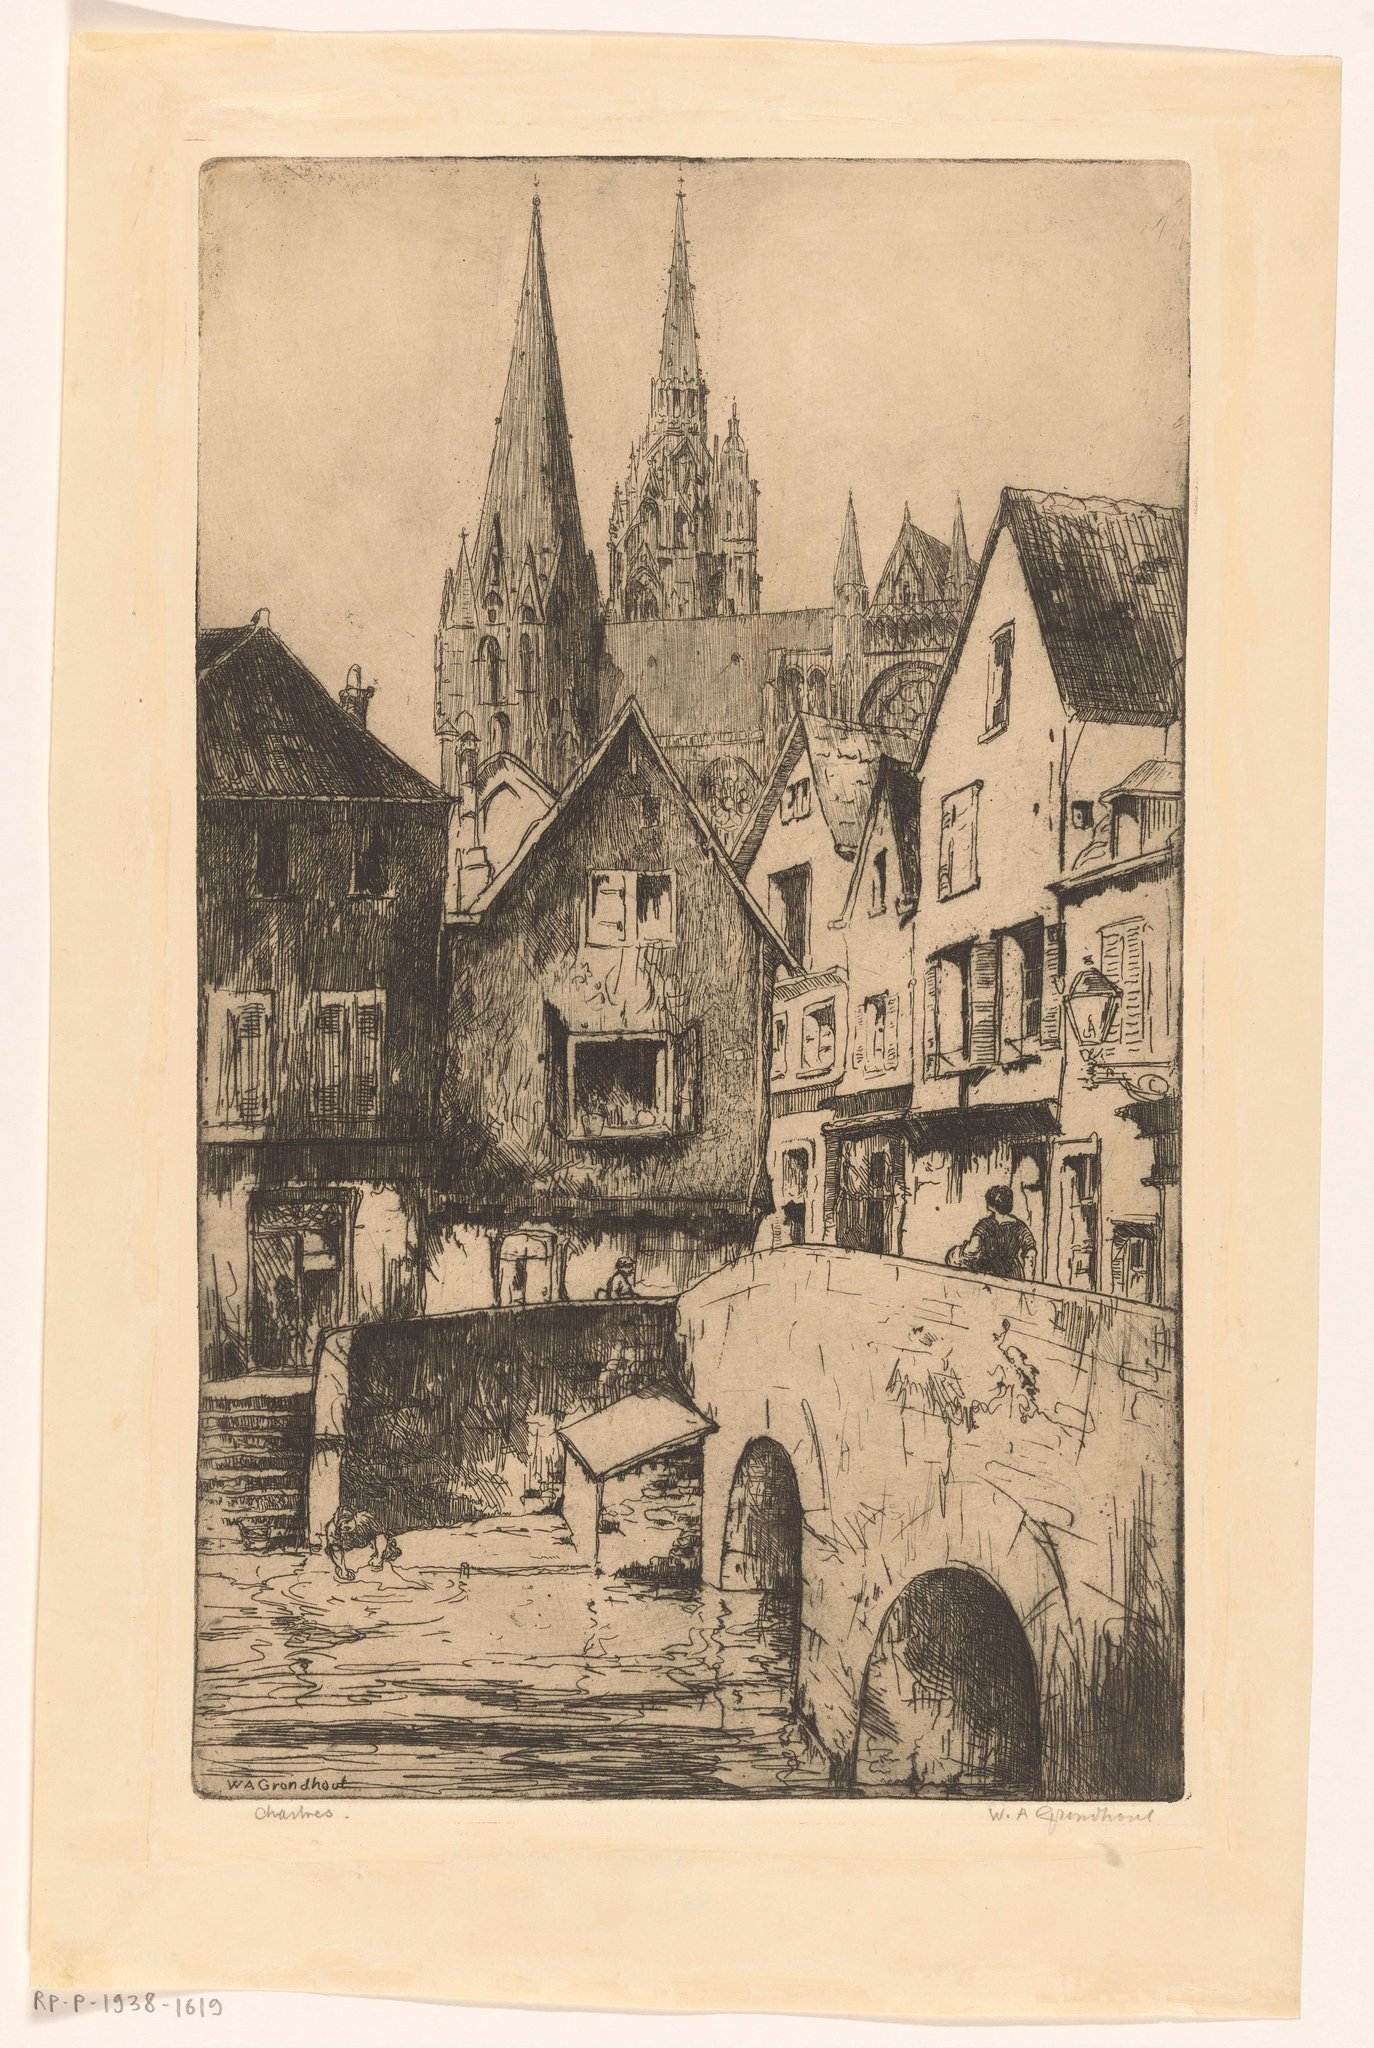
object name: print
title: Chartres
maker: willem adrianus grondhout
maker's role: draughtsman, painter, print maker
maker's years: 1878-1934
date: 1888-1934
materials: paper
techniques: etching, intaglio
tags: church (exterior), bridge in city across river, canal, etc.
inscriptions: collector's mark: Lugt 2228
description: Een brug over de Eure in Chartres, waarschijnlijk de Pont Bouju. Op de achtergrond de kathedraal van Chartres.